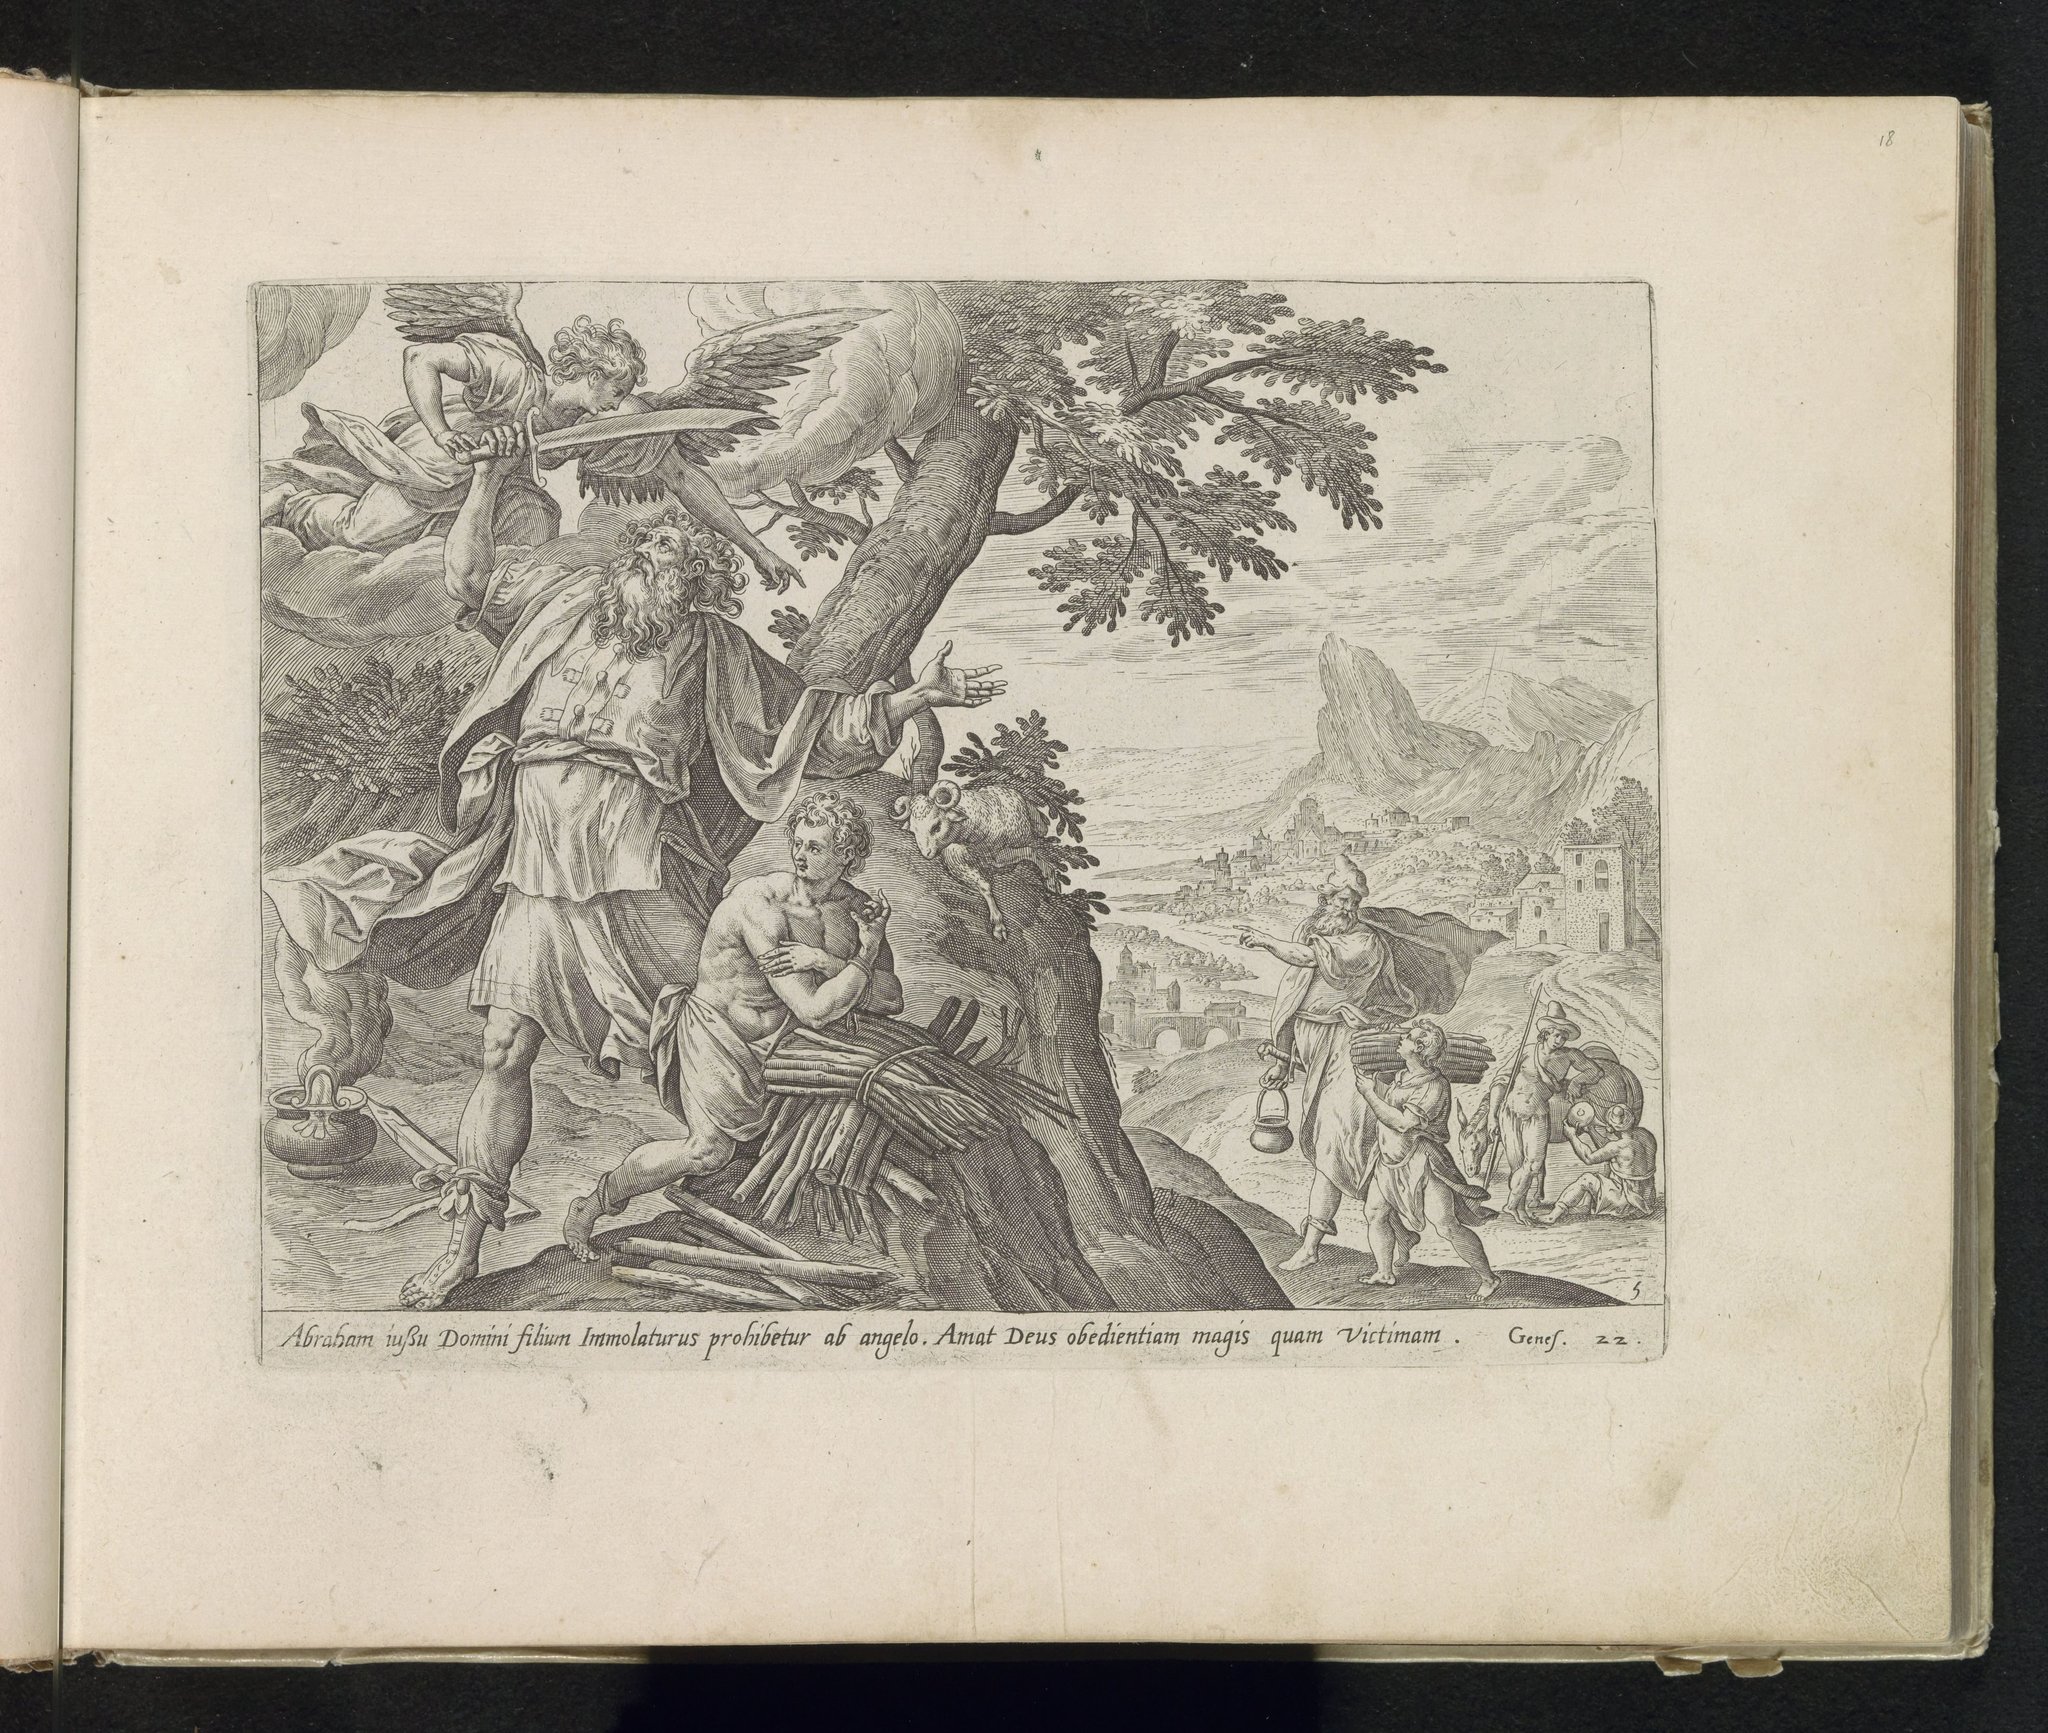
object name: album leaf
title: Offer van Isaak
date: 1585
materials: paper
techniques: engraving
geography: antwerp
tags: the servants are left behind while abraham and isaac (usually carrying wood) climb the mountain, when abraham has his hand raised to kill isaac, an angel restrains abraham's hand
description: Abraham heft zijn mes om zijn zoon Isaak te offeren, maar een engel weerhoudt hem daarvan. Rechts zit een ram in de struiken verstrikt, die in Isaaks plaats zal worden geofferd. Rechts in het landschap zijn Abraham en Isaak op weg naar de offerplaats, nadat ze de ezel en knechten hebben achtergelaten. Onder de voorstelling een verwijzing in het Latijn naar de Bijbeltekst in Gen. 22. Deze prent maakt deel uit van een album.